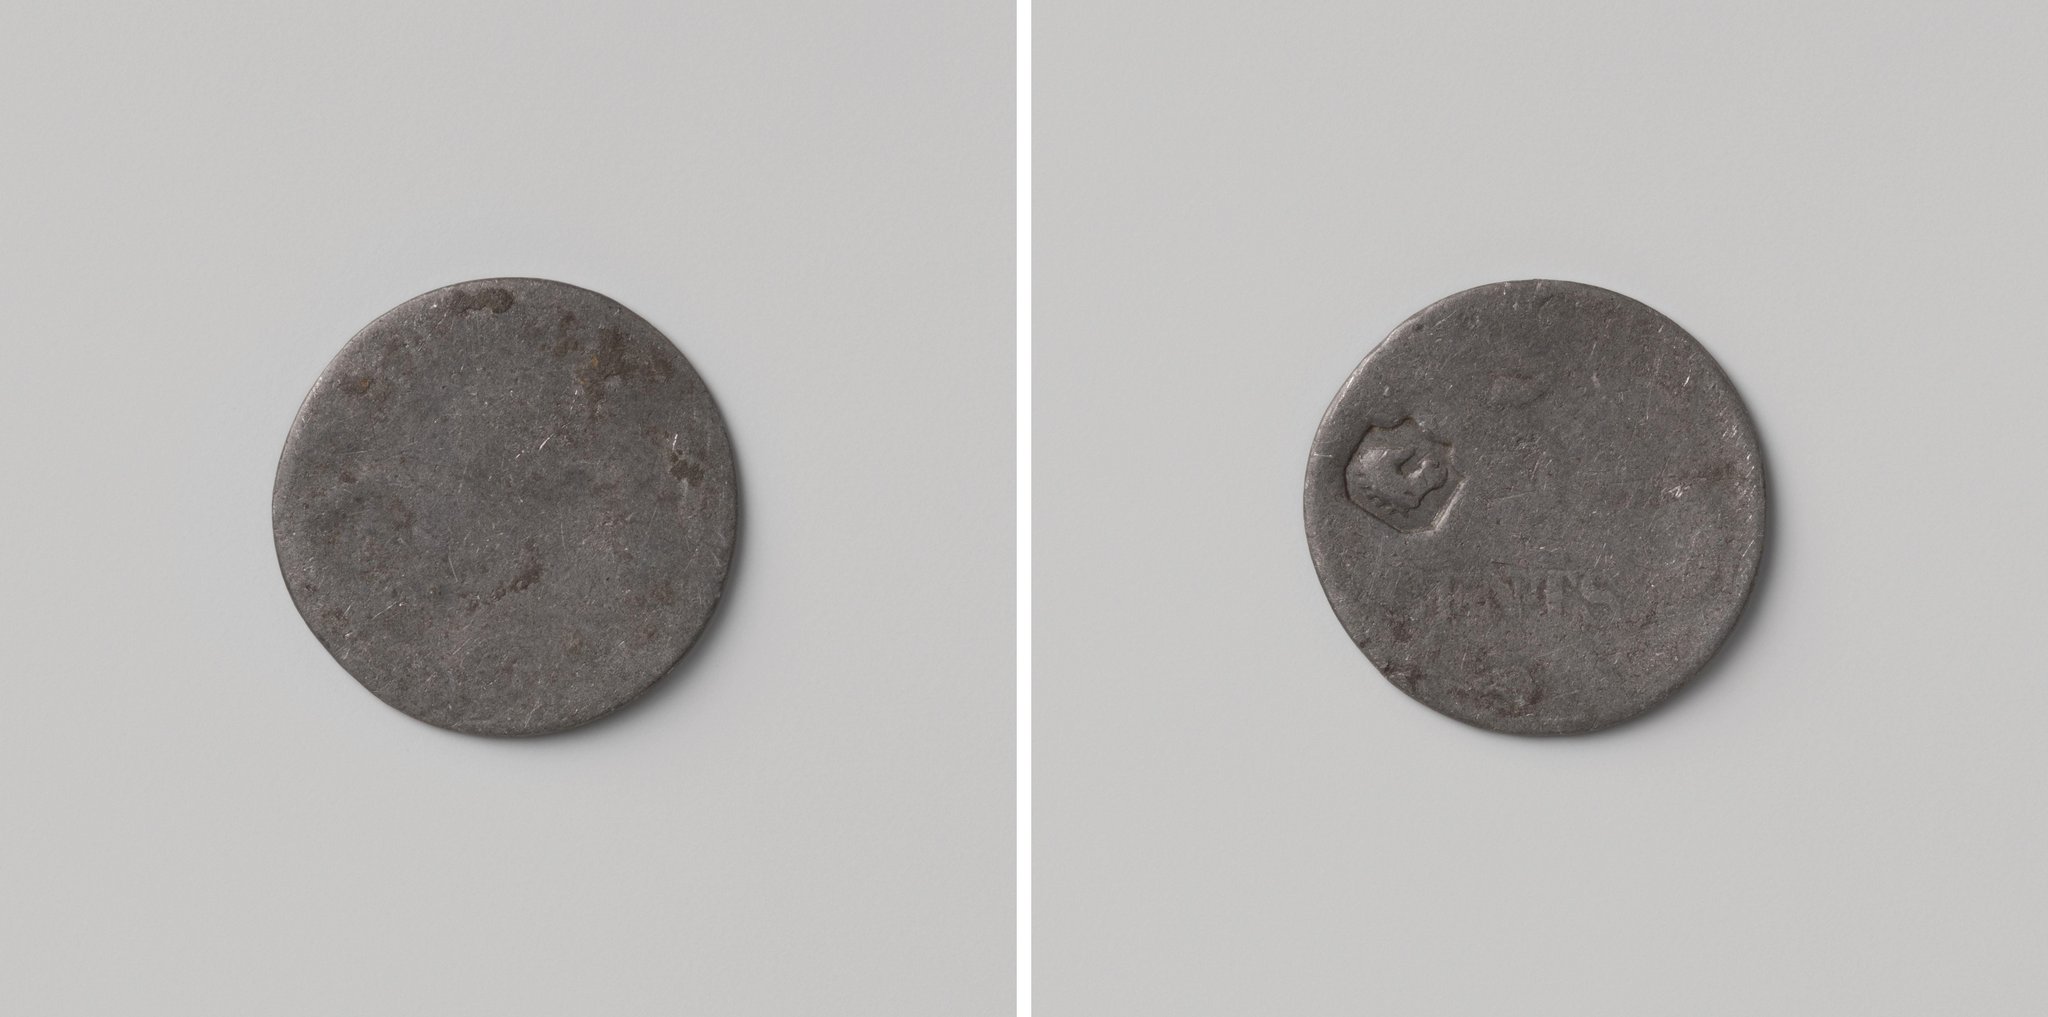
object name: vijf cent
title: Correctiehuis Sint Bernhard te Hemiksem, huismunt ter waarde van vijf cents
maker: joseph pierre braemt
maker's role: print maker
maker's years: 1796-1864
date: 1826-1833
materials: zinc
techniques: striking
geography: brussels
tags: ghent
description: Zinken betaalpenning. Voorzijde: opschrift binnen omschrift. Keerzijde: waardeaanduiding; links klop: paardekop.